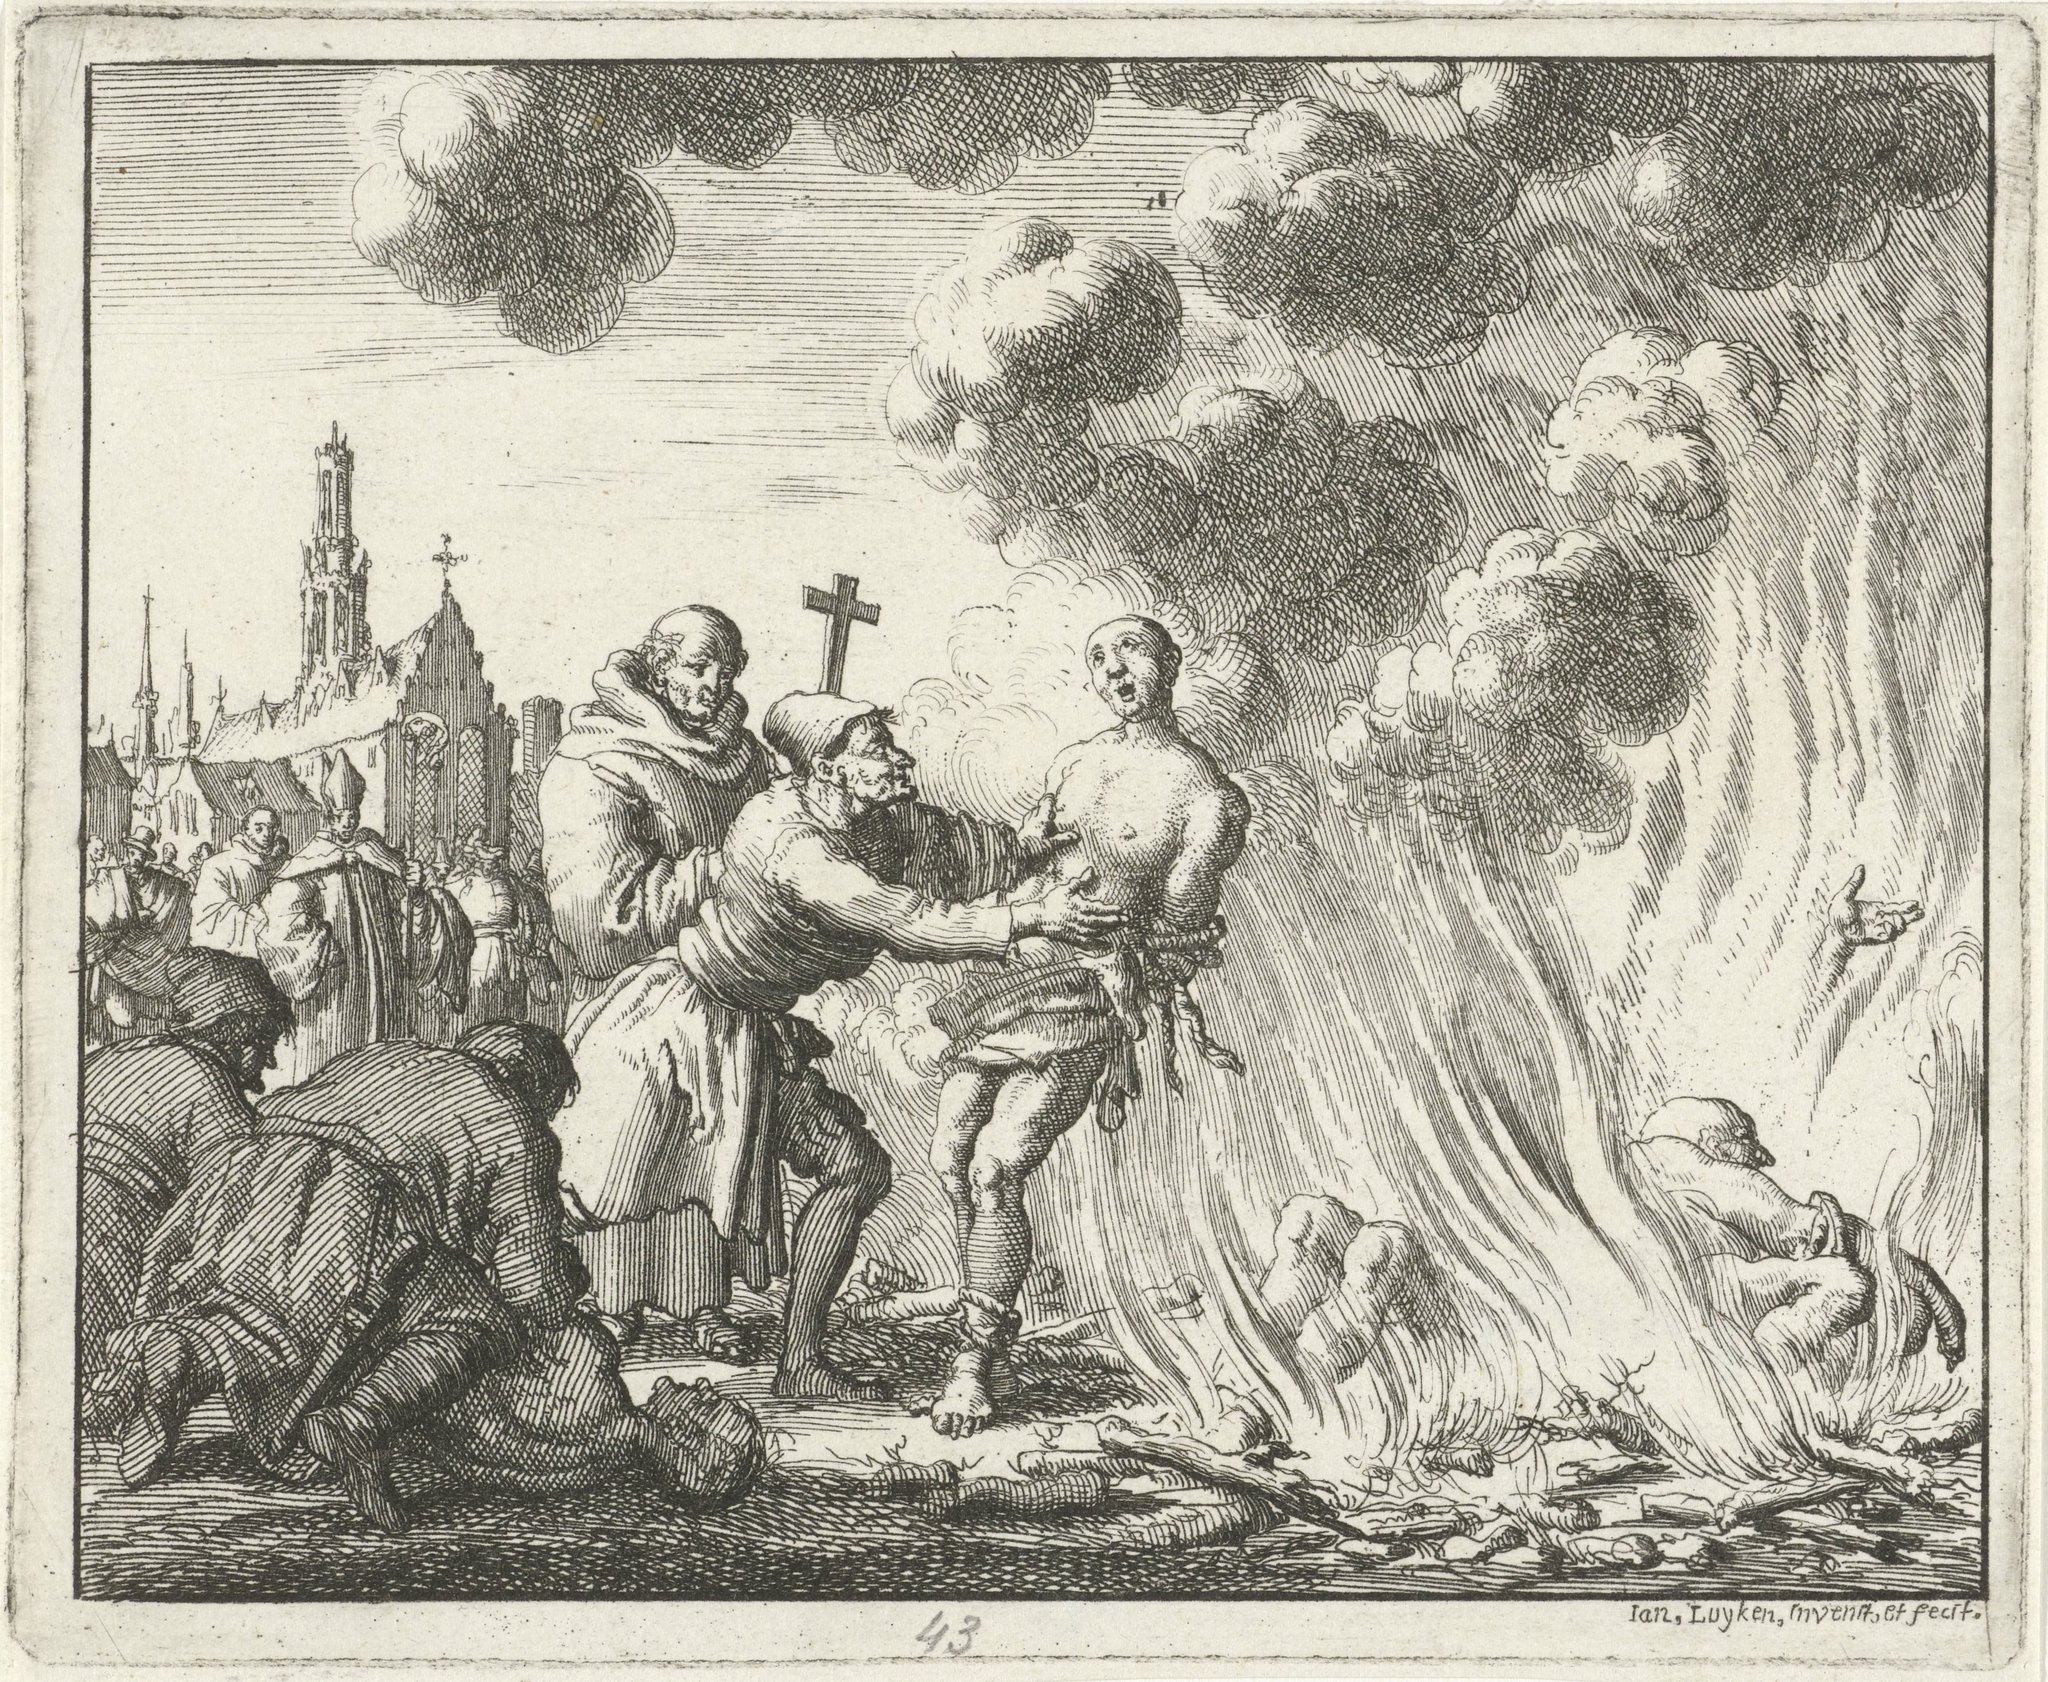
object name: book illustration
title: Publicani in Engeland en Frankrijk verbrand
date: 1685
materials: paper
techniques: etching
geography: amsterdam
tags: violent death by burning at the stake; pyre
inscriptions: collector's mark: Lugt 2228, number: ‘43’